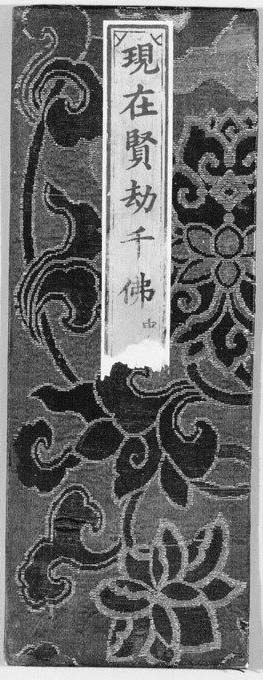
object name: sutra cover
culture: chinese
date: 1501-1700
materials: metal thread, silk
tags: flowers